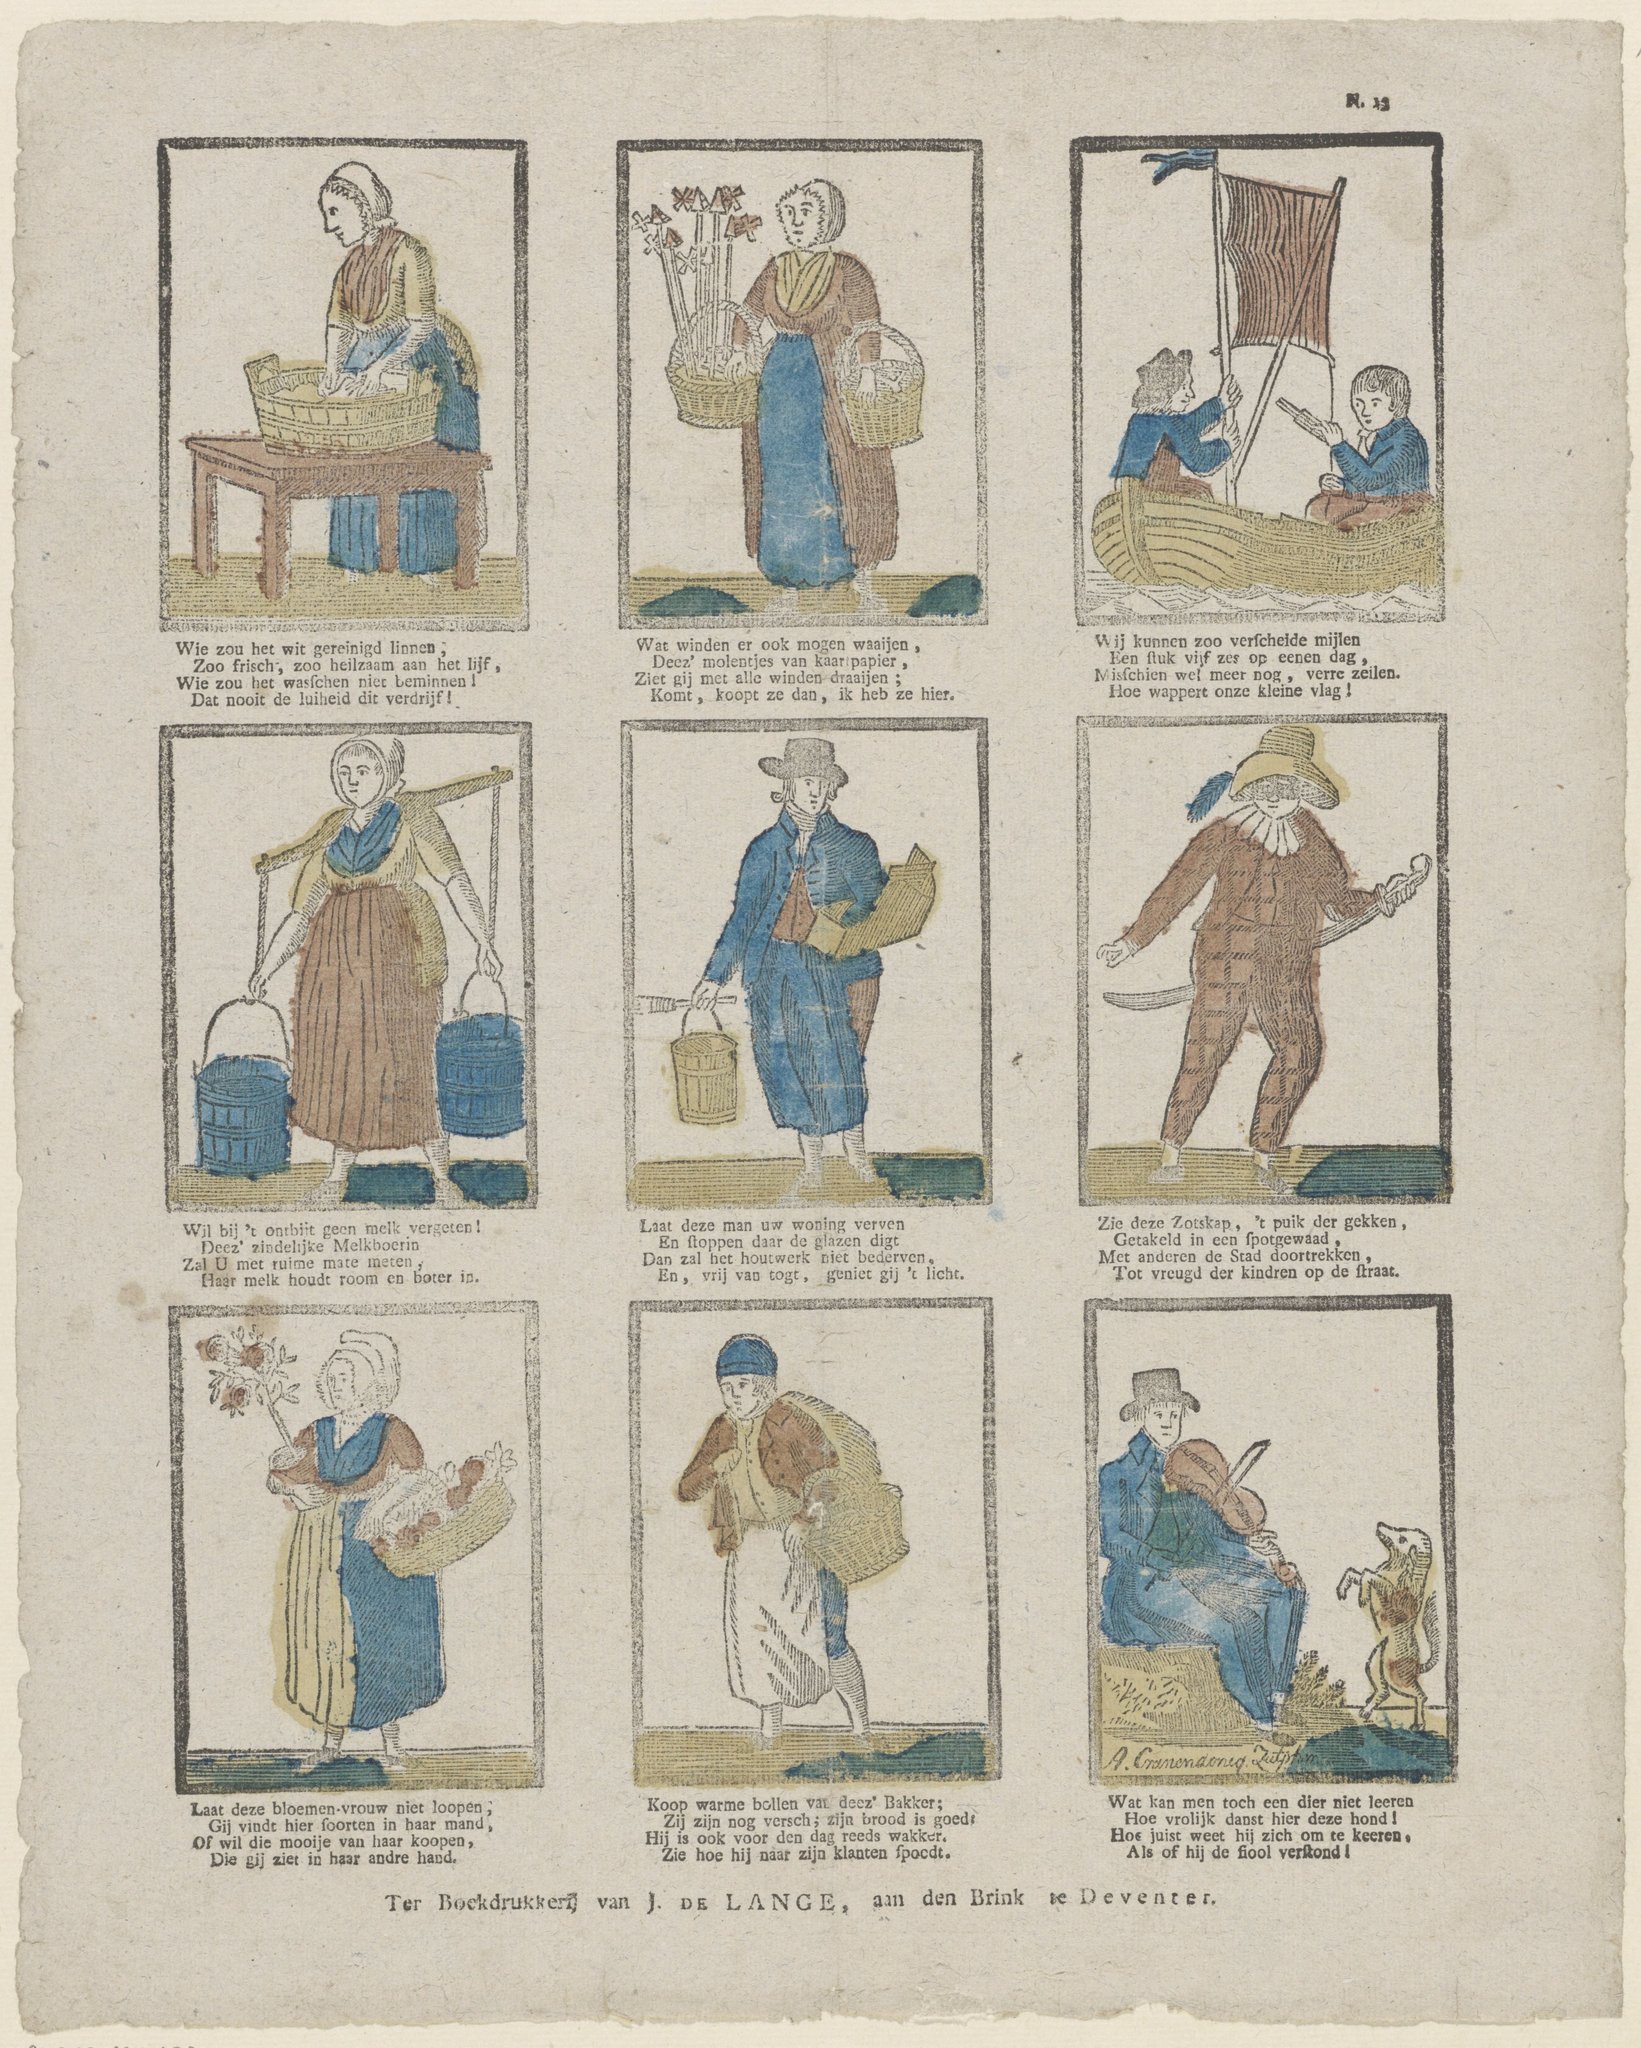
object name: popular print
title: Verschillende figuren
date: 1822-1849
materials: paper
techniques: colour, letterpress printing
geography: deventer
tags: musician at work, human types, child, street-trader, merchant, salesman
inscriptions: collector's mark: Lugt 2760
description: Blad met 9 voorstellingen van verschillende figuren, zoals straatverkopers en een violist. Onder elke afbeelding een vierregelig vers. Genummerd rechtsboven: N. 13.